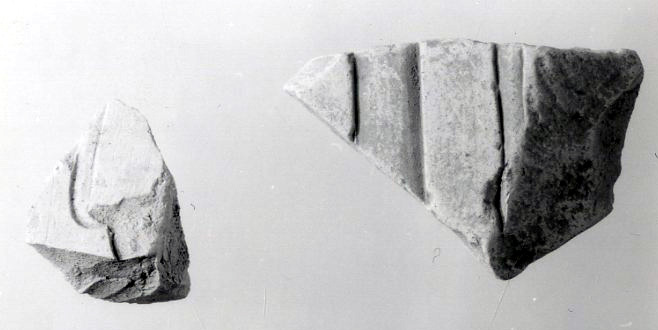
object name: relief fragment, tomb of meketre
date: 1981-1975 BCE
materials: limestone, paint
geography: egypt